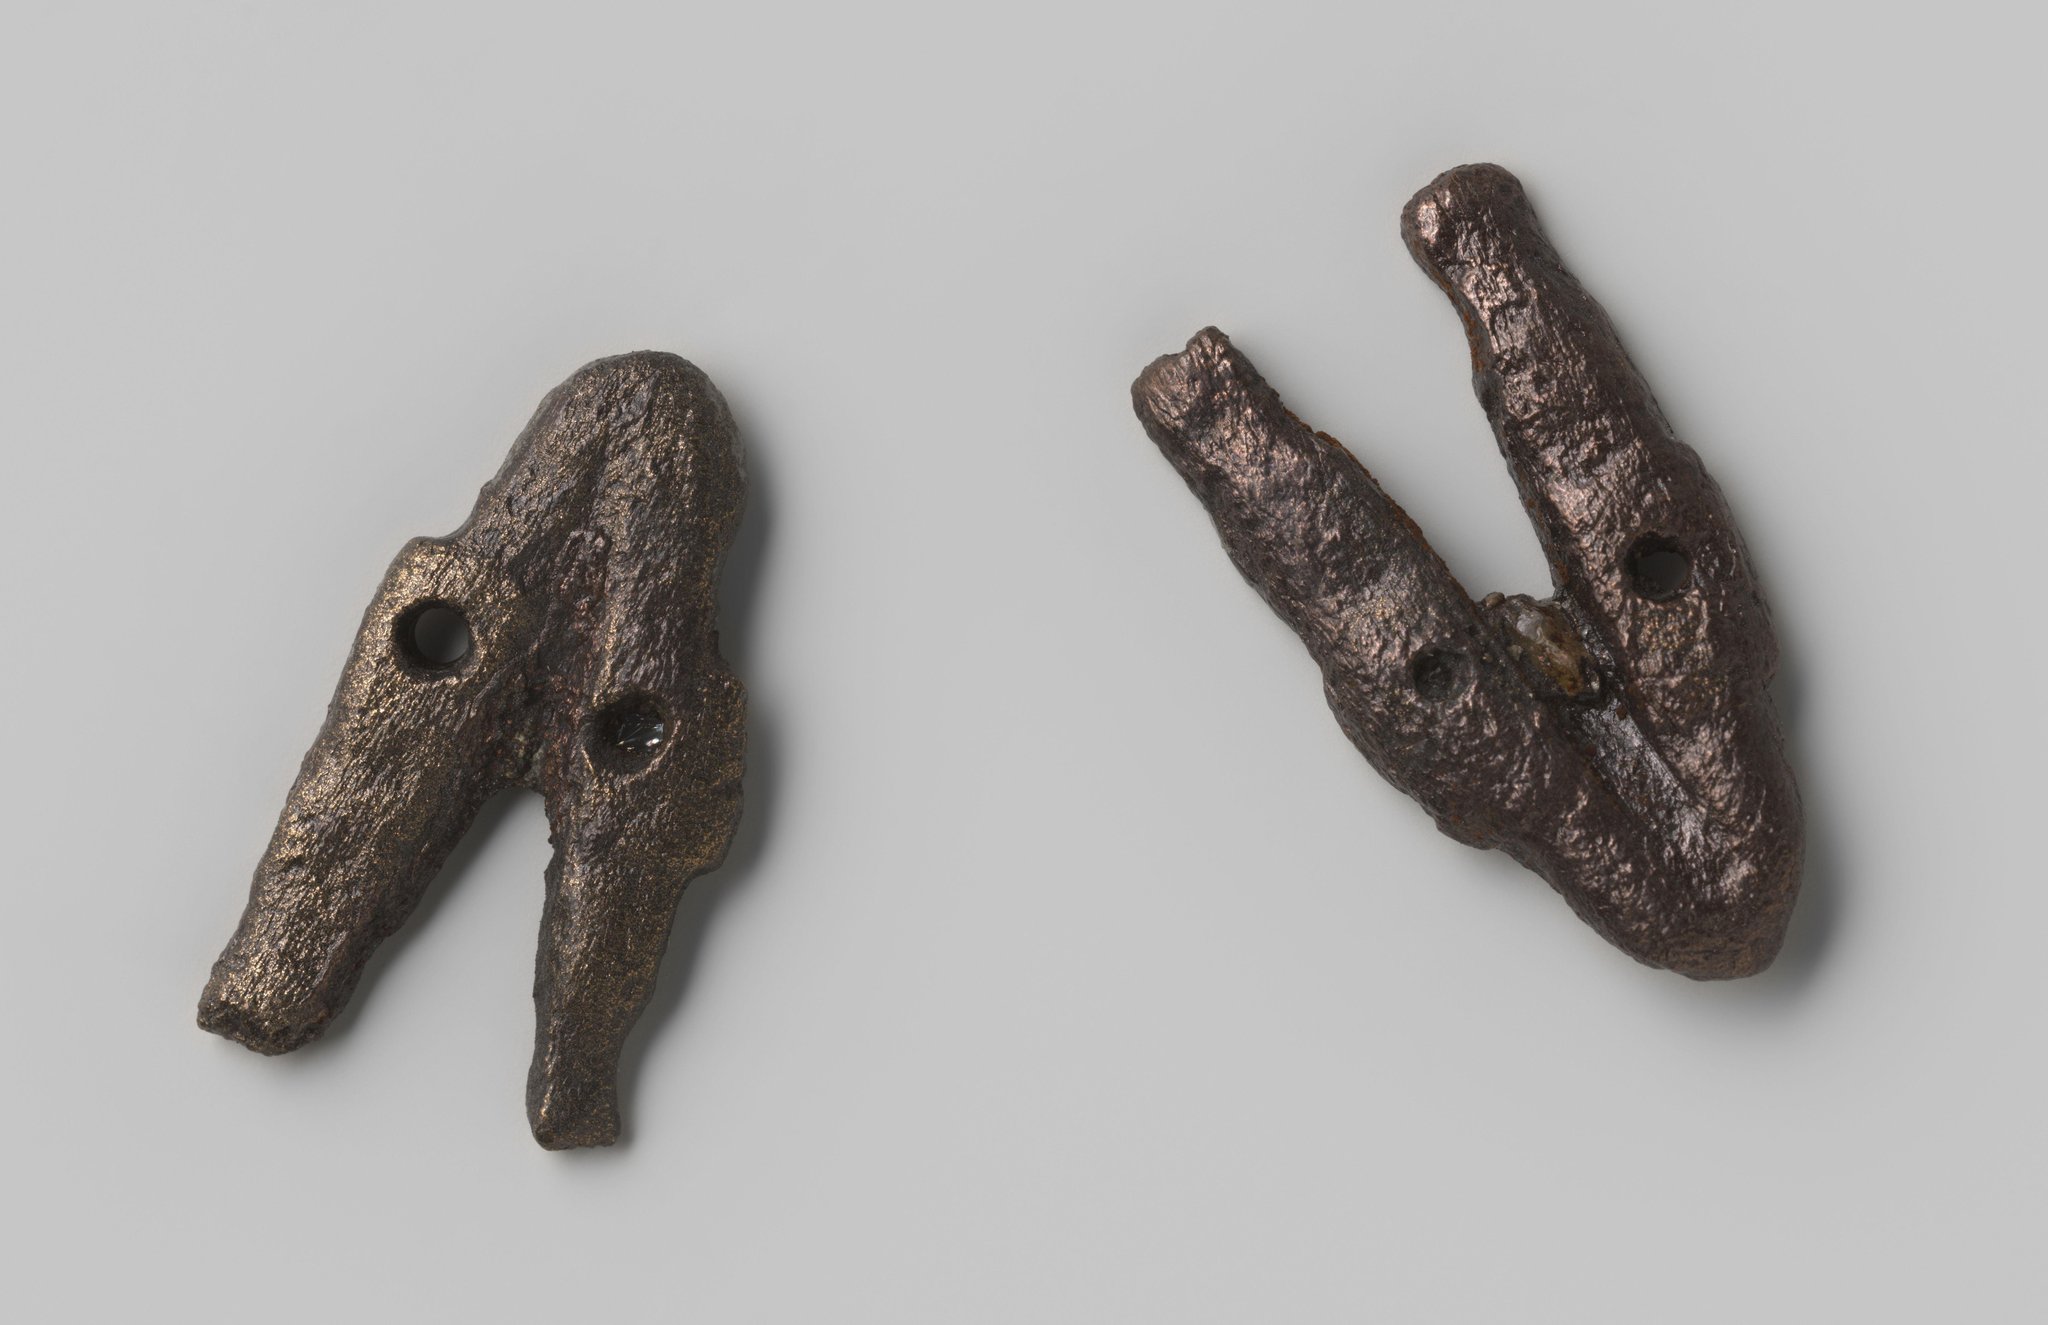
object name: scharnier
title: Scharnieren van een sluitgewicht uit het wrak van de Oost-Indiëvaarder Hollandia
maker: Anonymous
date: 1700-1743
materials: copper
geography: netherlands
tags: verenigde oostindische compagnie, hollandia (schip), annet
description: Weight, cupweight, locks and hinges; fragm of hinges, id. NG 1980-27H84.